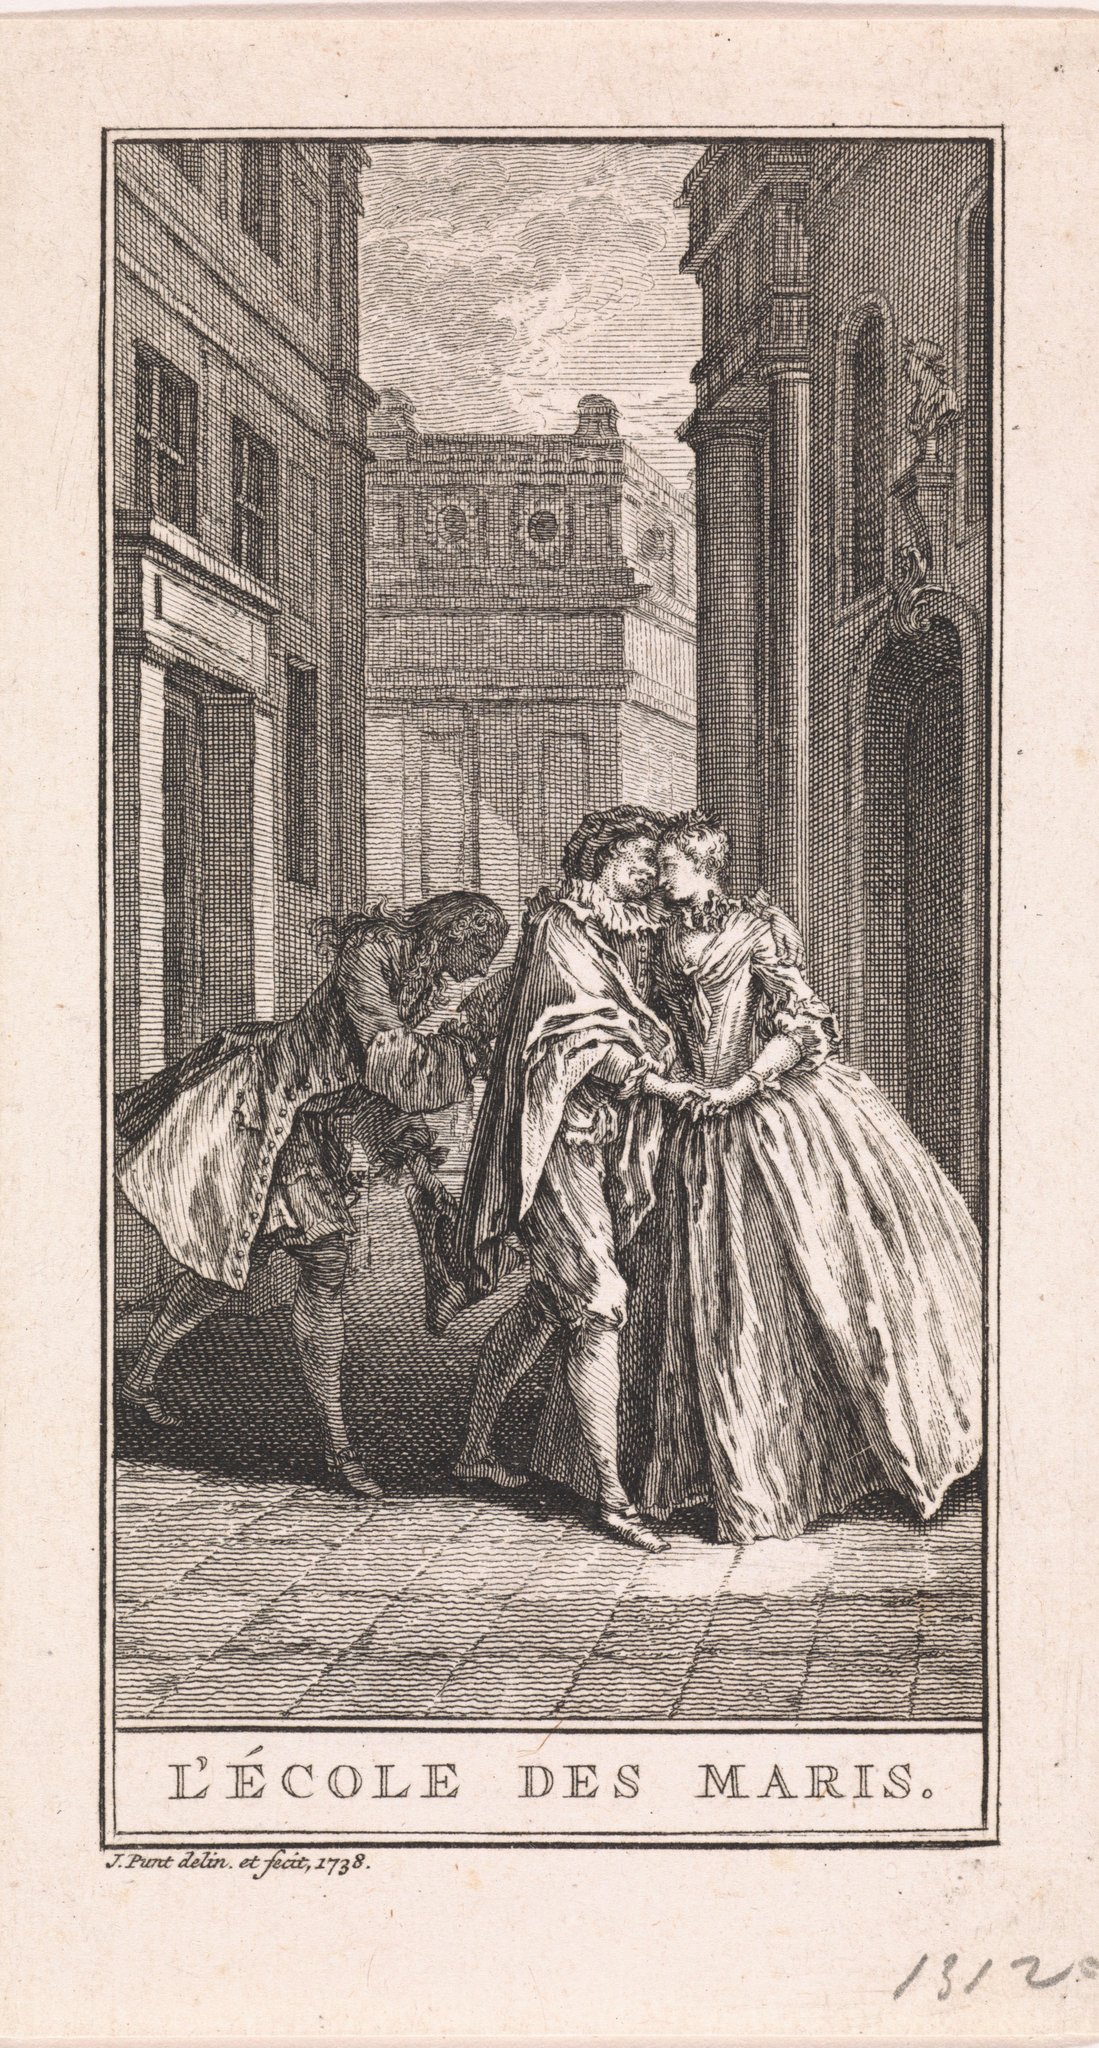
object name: print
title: Liefdespaar in omhelzing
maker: jan punt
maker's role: draughtsman, print maker, publisher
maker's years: 1711-1779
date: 1738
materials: paper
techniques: engraving, etching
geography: amsterdam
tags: (moliere) specific works of literature (with author, title), couple of lovers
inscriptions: collector's mark: Lugt 2228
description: Op straat voor de ingang van een gebouw omhelst een paar elkaar. Achter hen kust een man de hand van een vrouw. Scène uit het toneelstuk L'École des maris, van Molière.